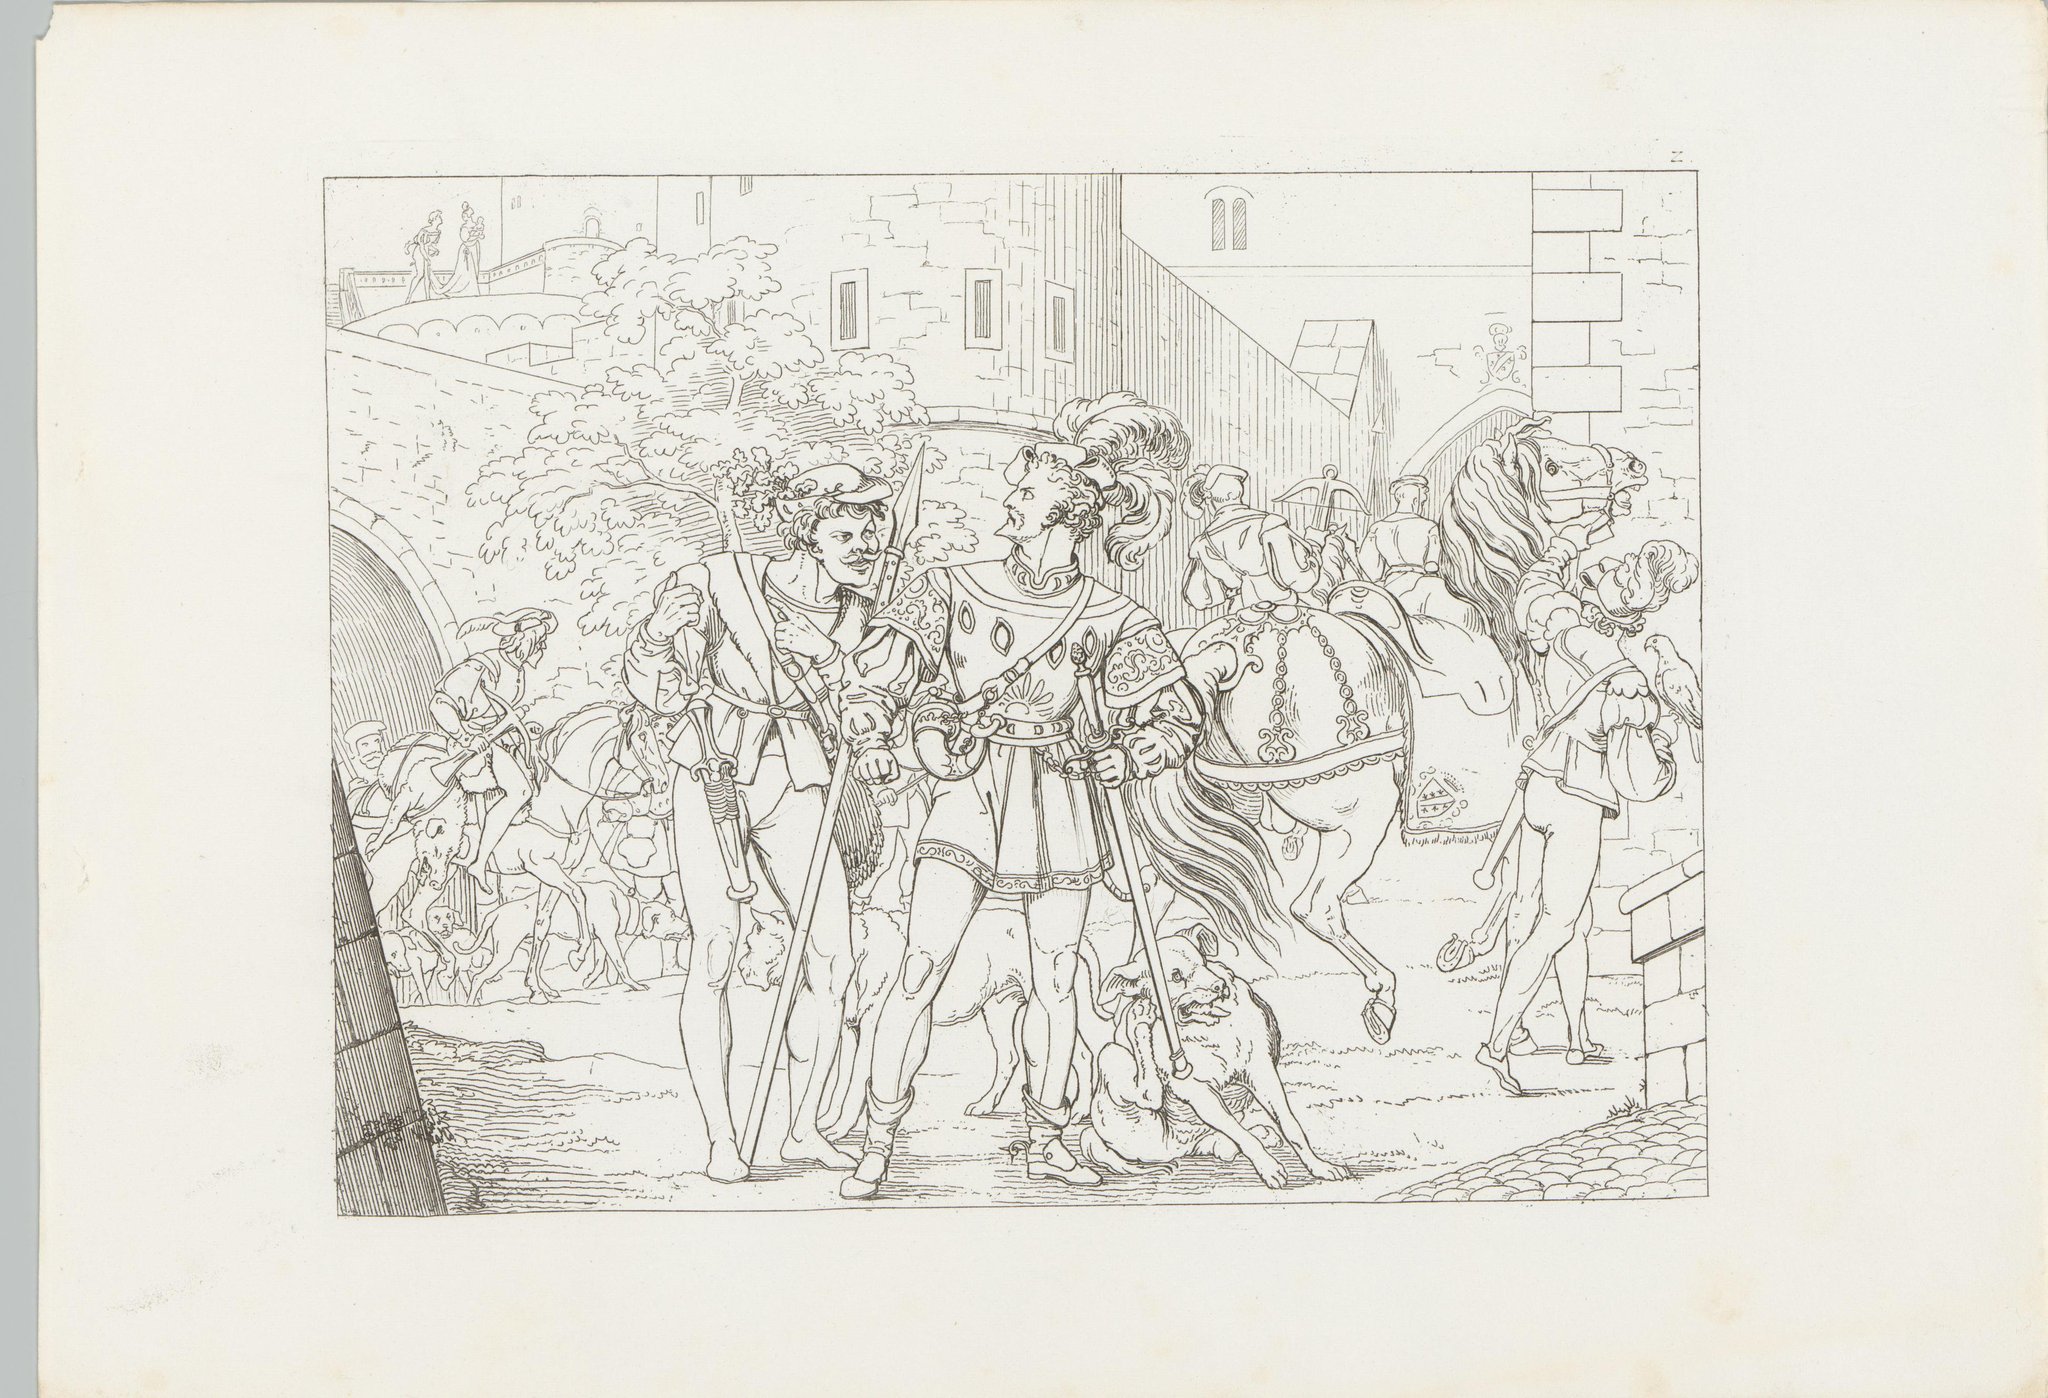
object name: print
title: Umrisse zu Schiller's Fridolin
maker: moritz retzsch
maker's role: print maker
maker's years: 1779-1857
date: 1823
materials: paper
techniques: etching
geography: tübingen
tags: castle, the soldier; the soldier's life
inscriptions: date